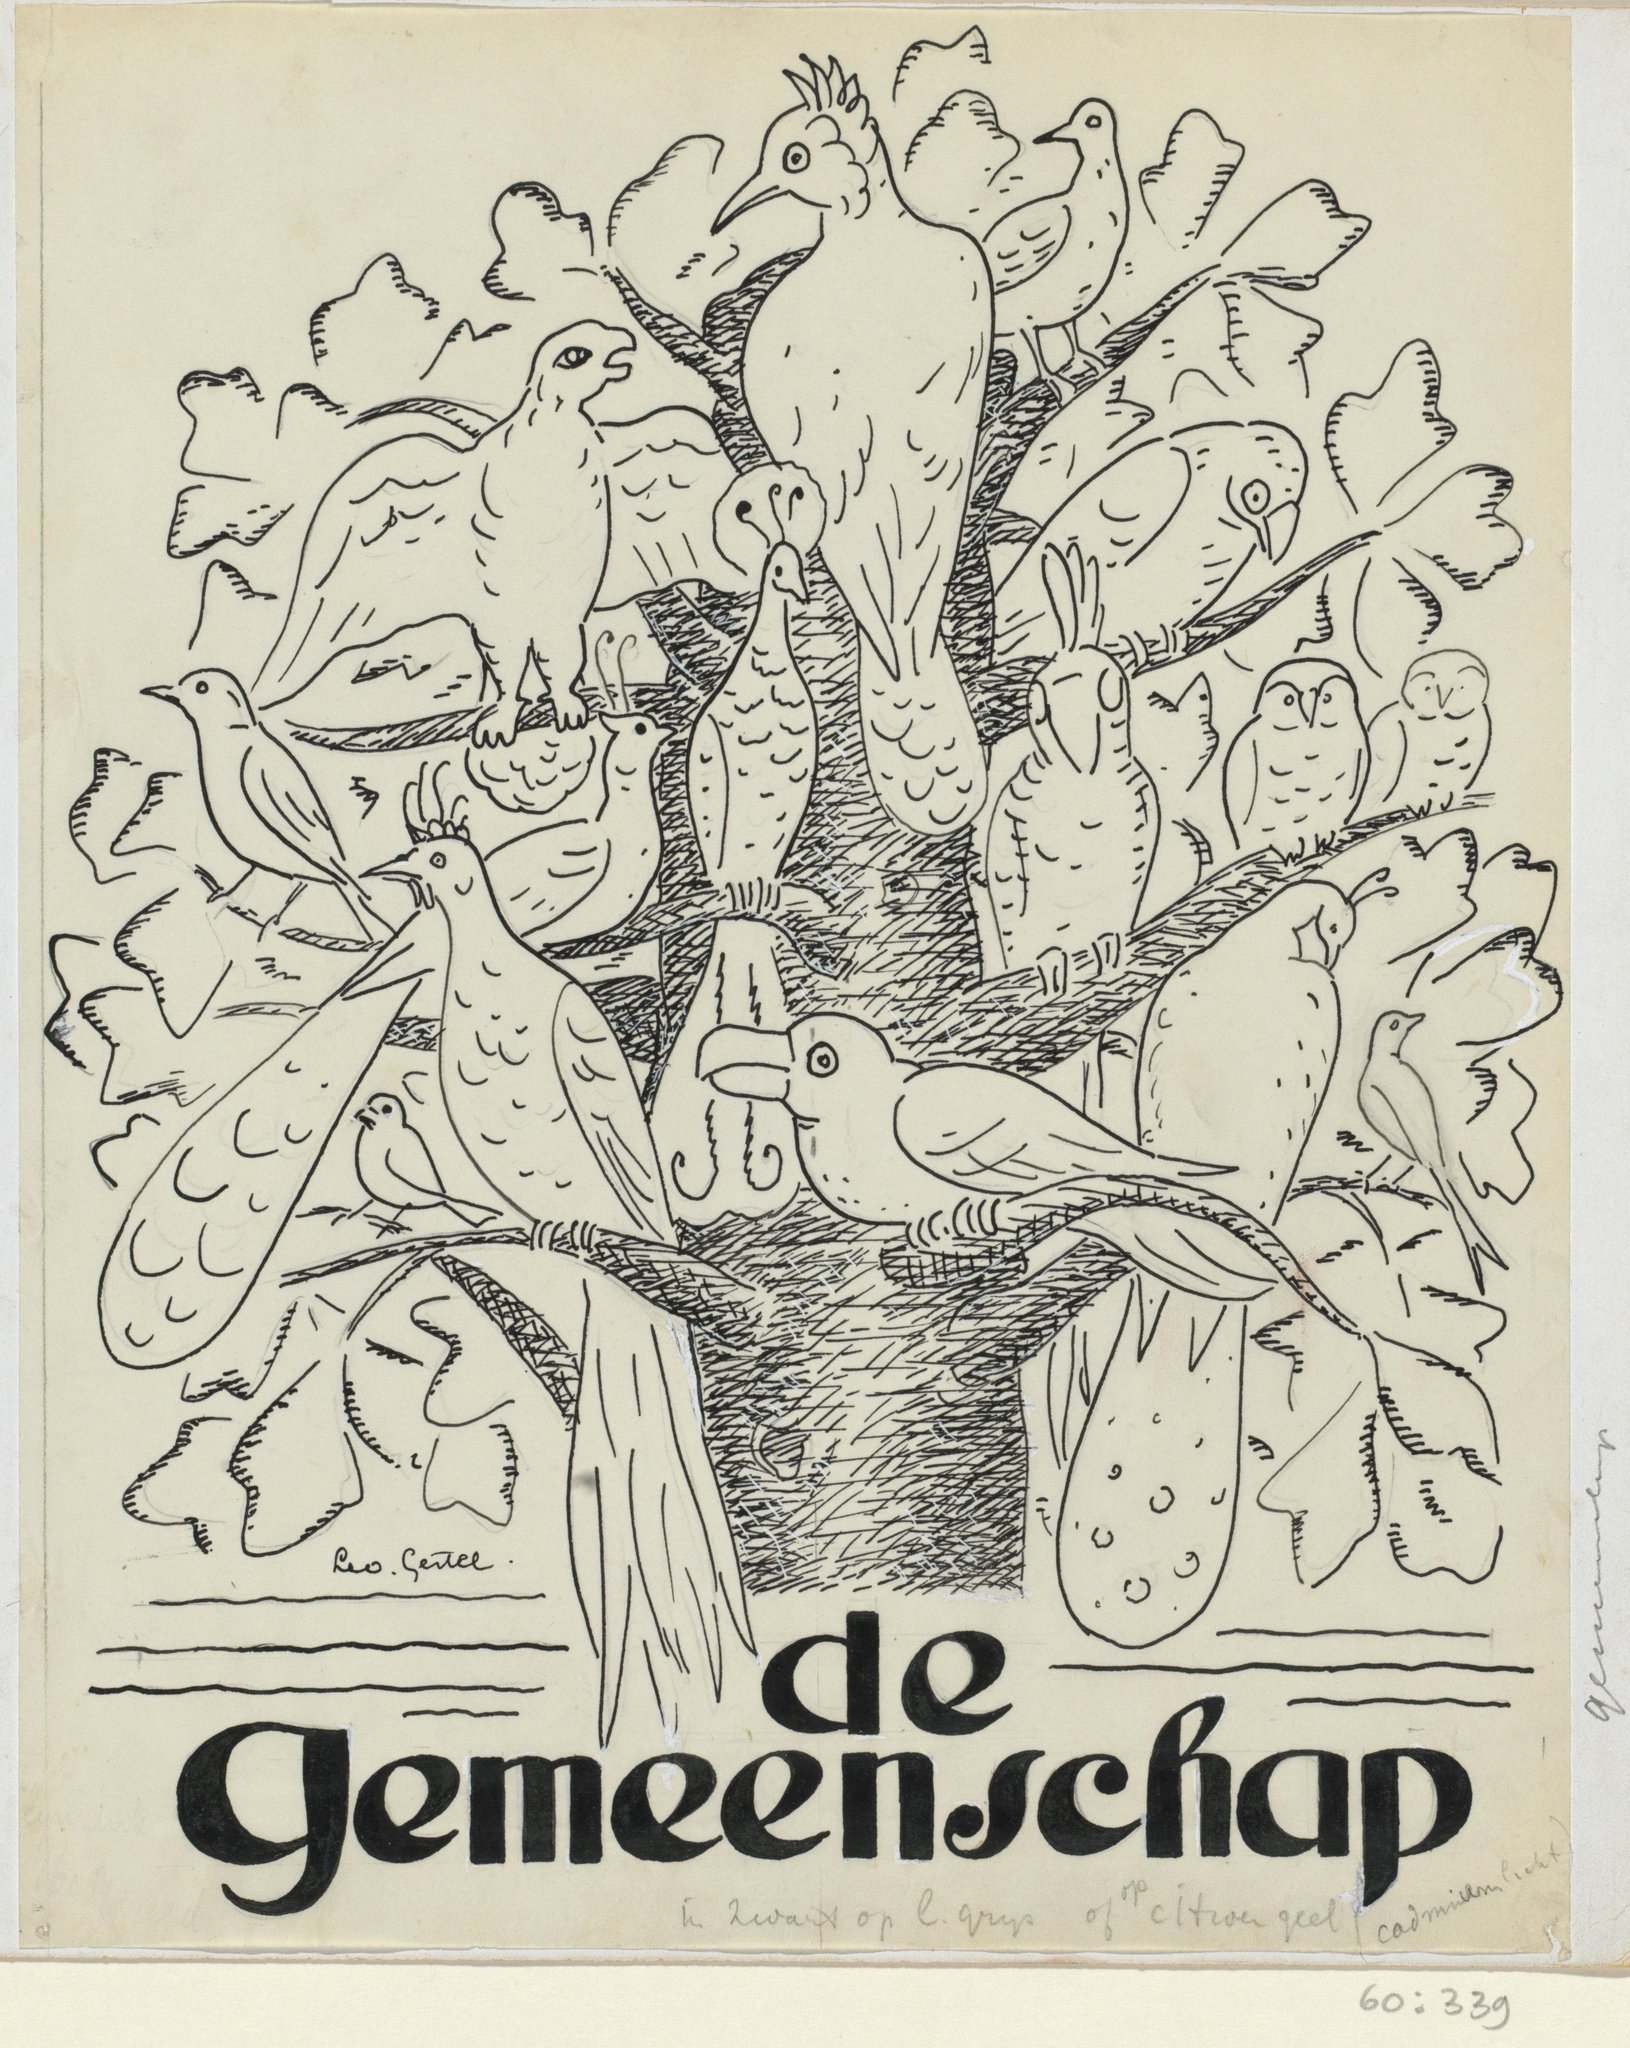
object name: design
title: Vogels in een boom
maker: leo gestel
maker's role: draughtsman, print maker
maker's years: 1881-1941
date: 1935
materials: paint, ink, paper, pencil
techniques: pen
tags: trees, (other) historical names, groups of birds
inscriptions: collector's mark: Lugt 2228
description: Ontwerp voor de omslag van: De Gemeenschap, 1935.